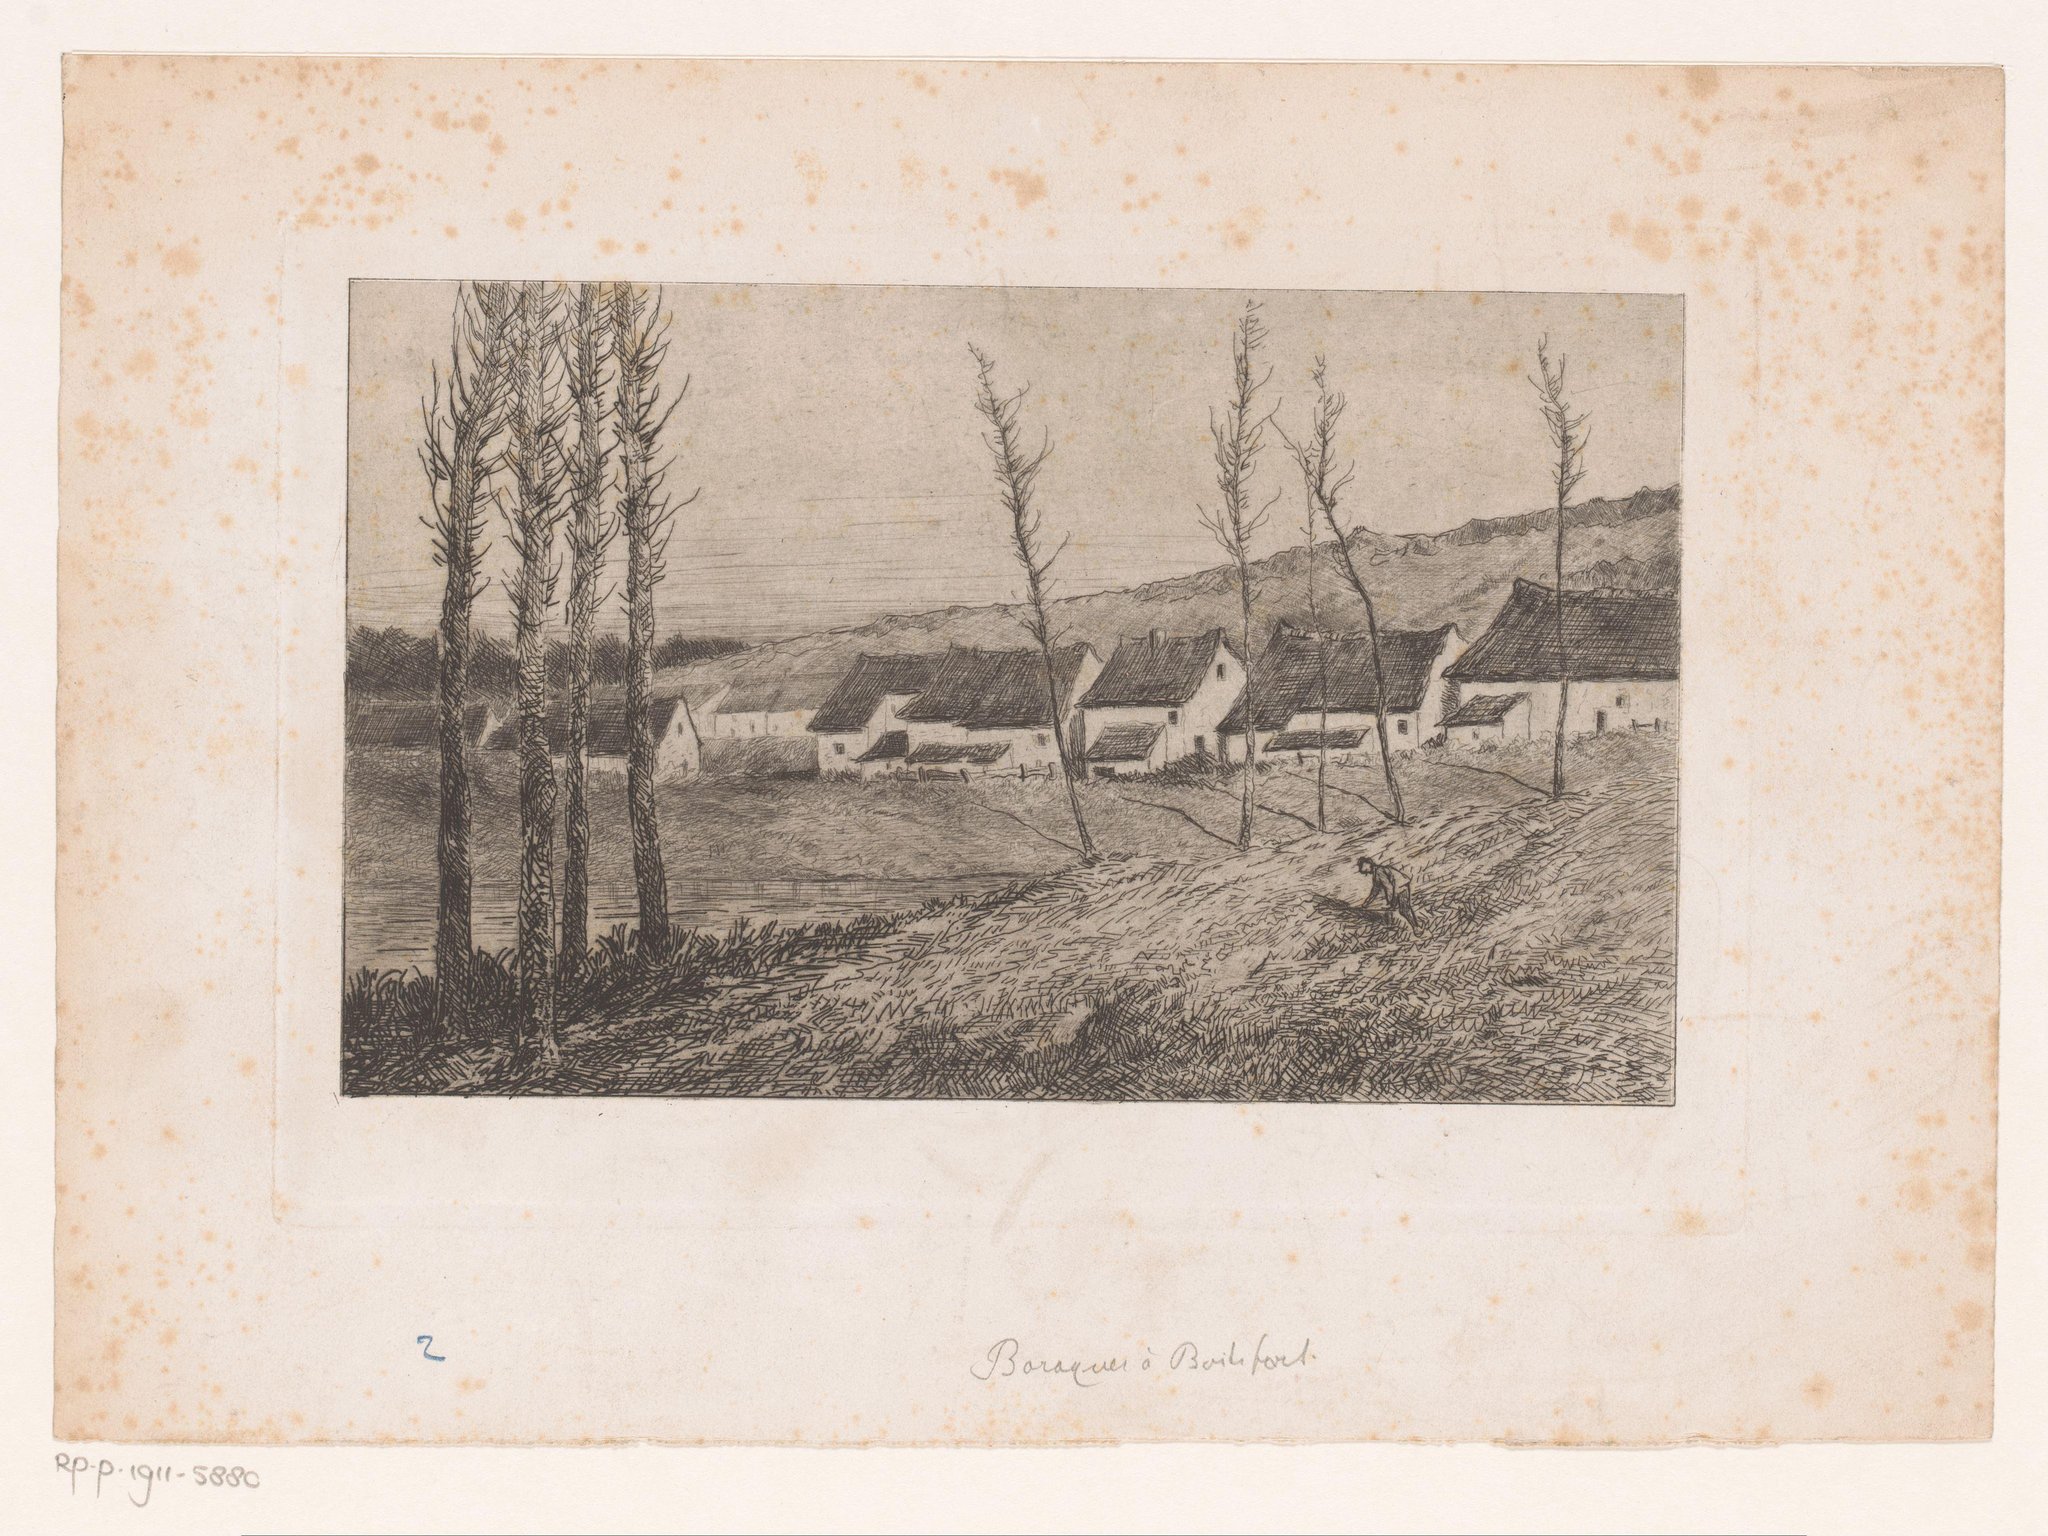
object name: print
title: Huizen in Bosvoorde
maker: adrien le mayeur de merprés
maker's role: print maker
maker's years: 1844-1923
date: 1854-1911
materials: paper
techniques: etching, intaglio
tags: prospect of village, silhouette of village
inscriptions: annotation: ‘Baraques à Boitsfort’, collector's mark: Lugt 2228